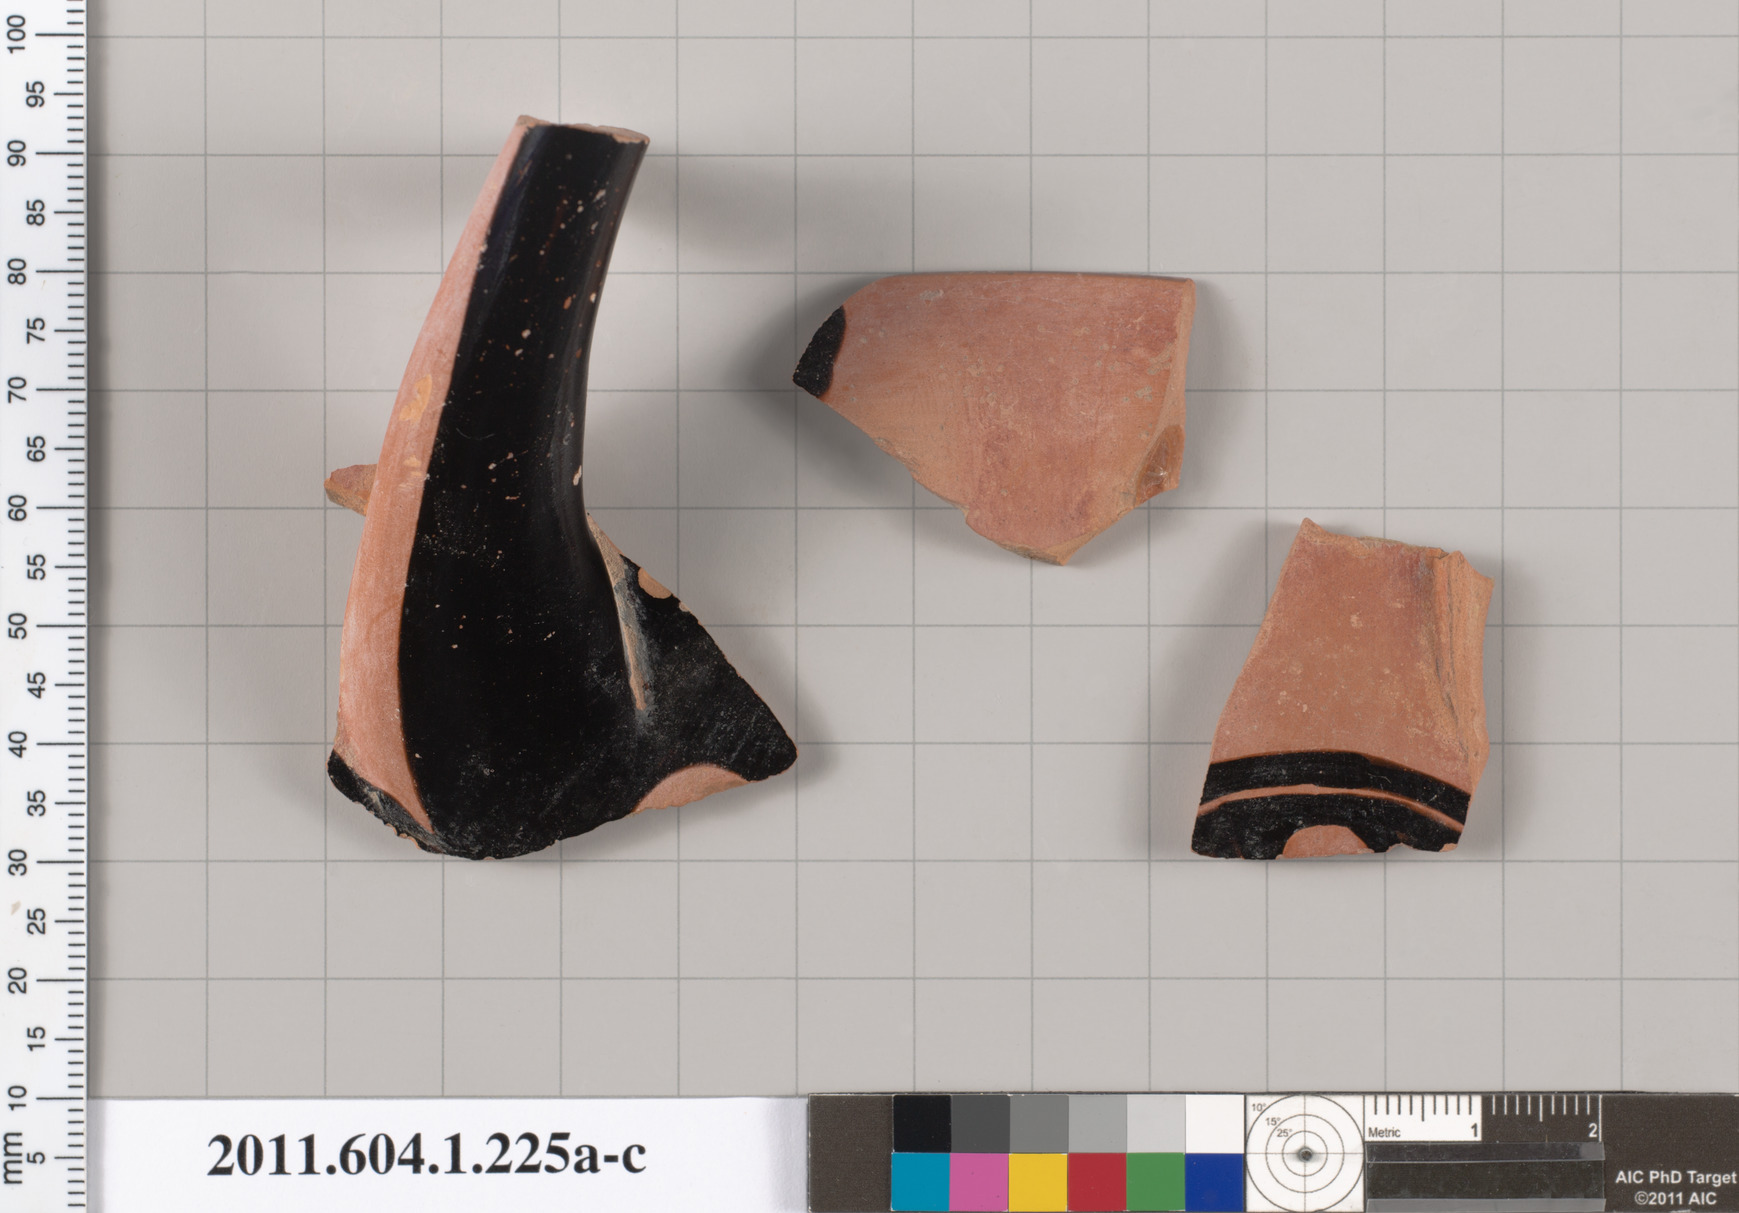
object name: kylix fragment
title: Terracotta fragments of a kylix (drinking cup)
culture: greek, attic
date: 475-451 BCE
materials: terracotta